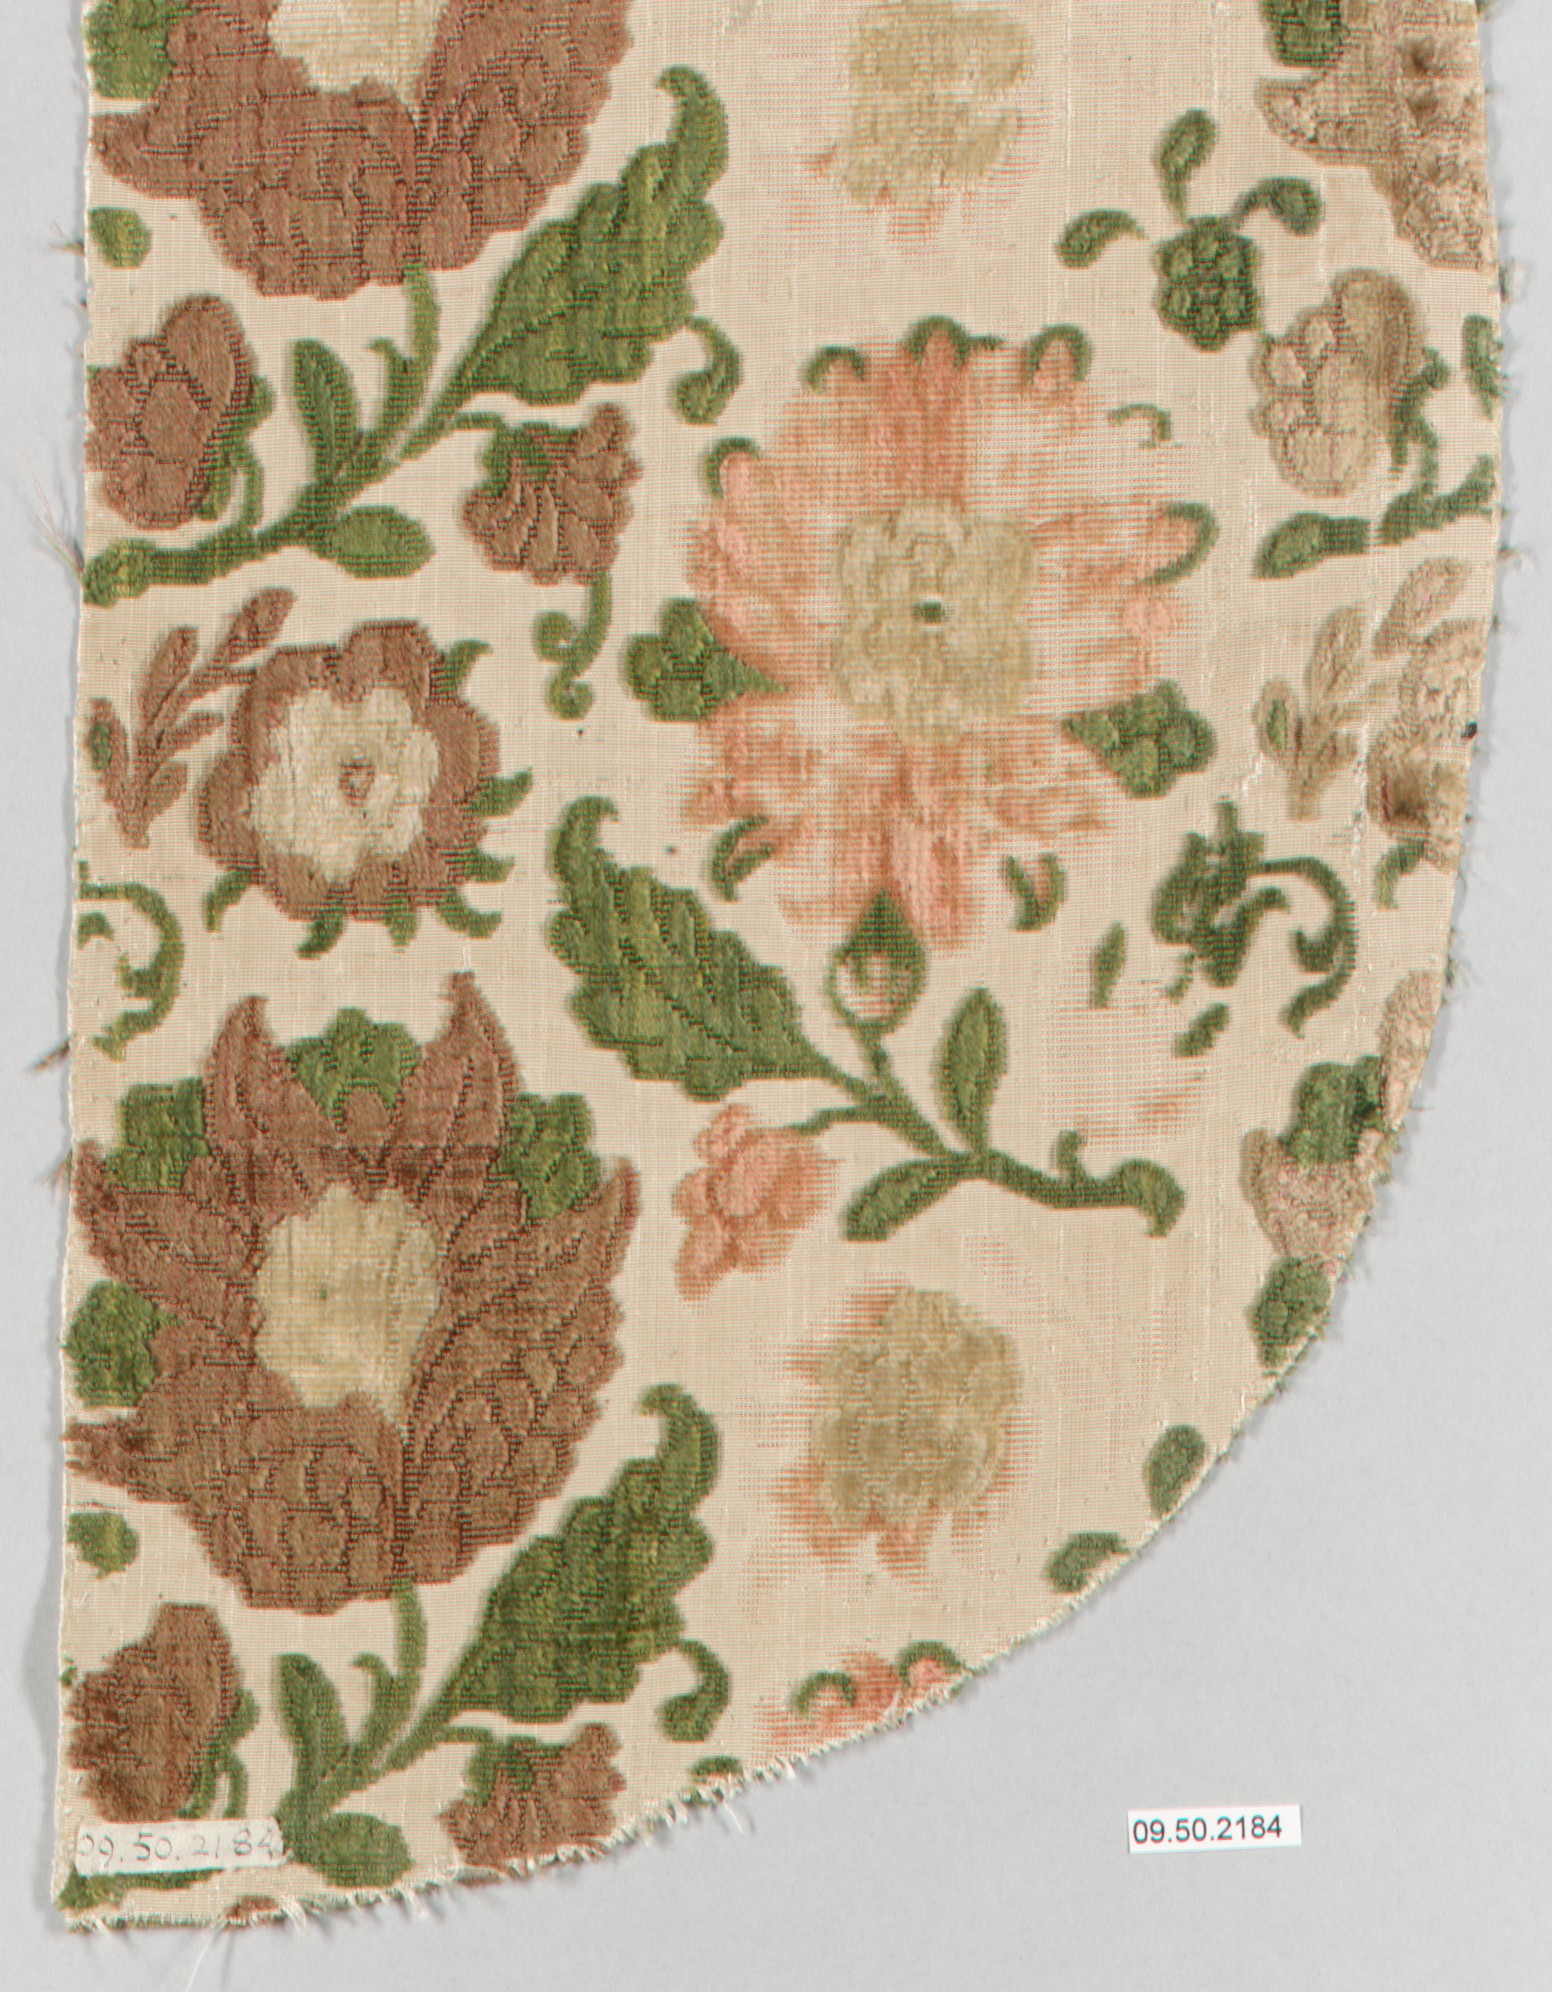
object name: piece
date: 1501-1700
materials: silk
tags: flowers,leaves